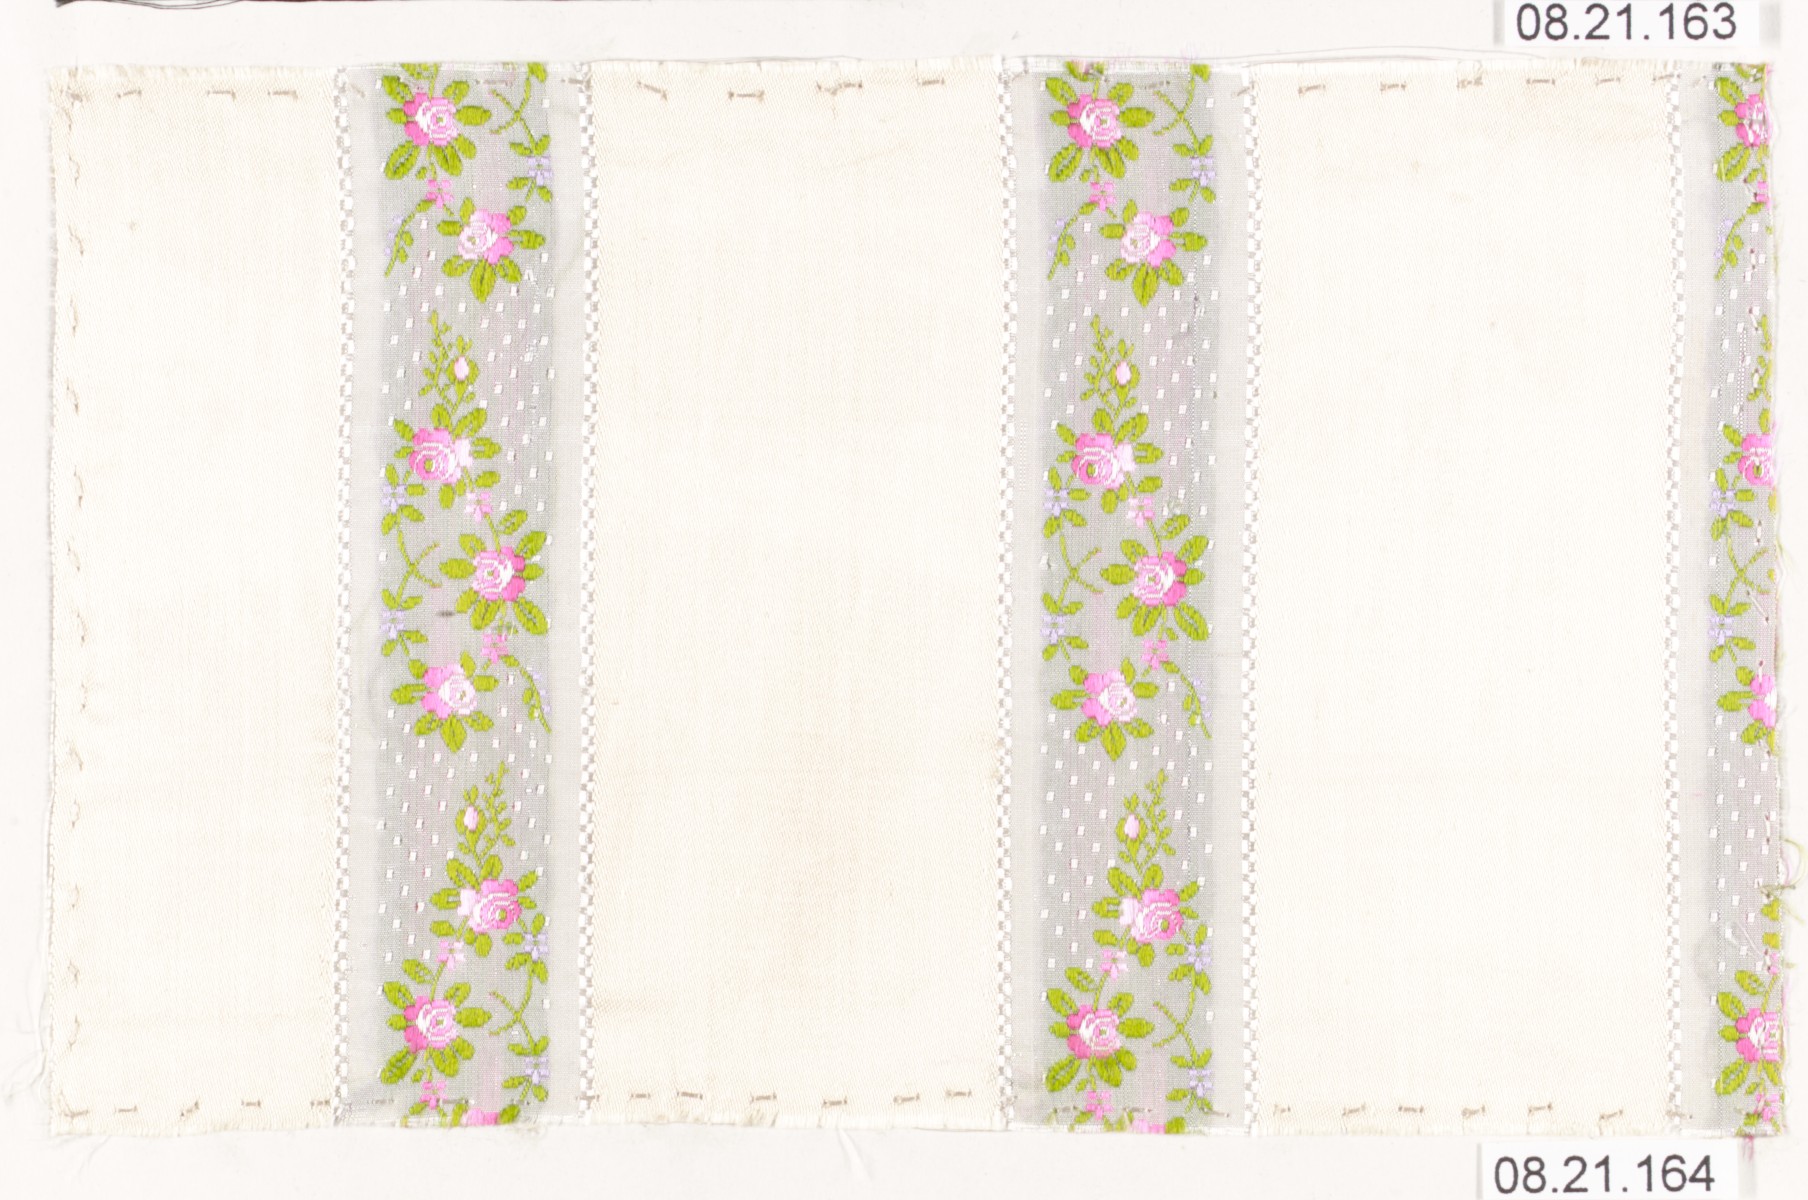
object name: textile sample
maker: Anonymous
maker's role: designer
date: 1900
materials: silk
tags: flowers